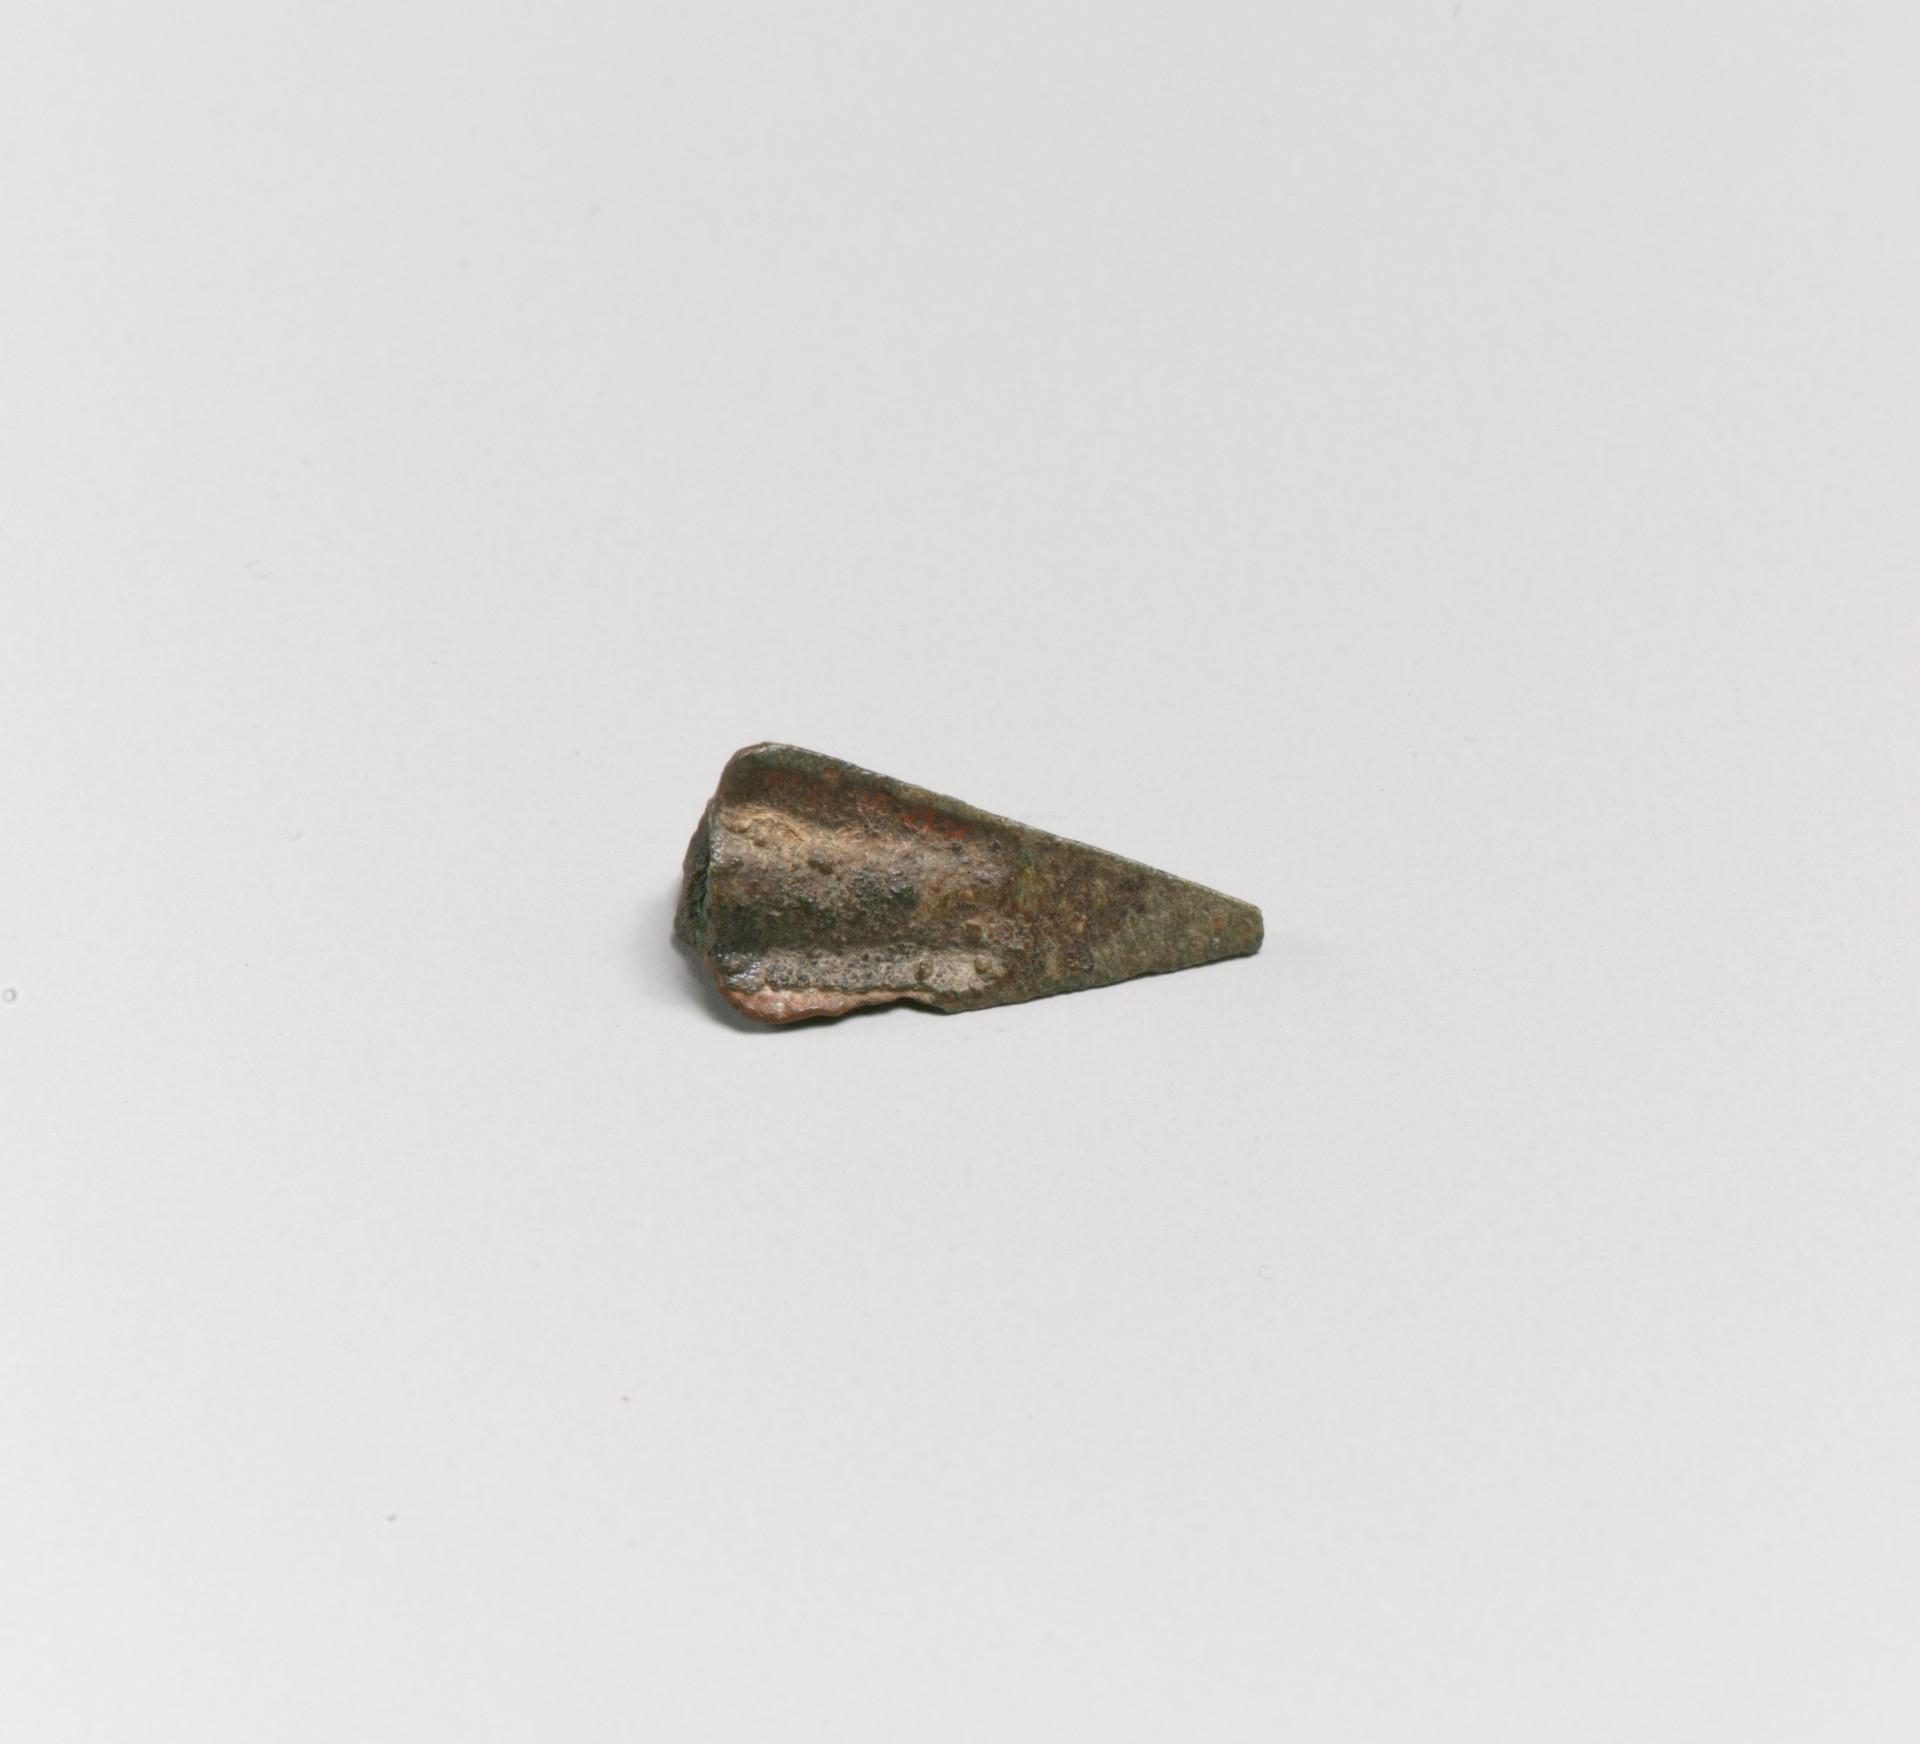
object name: arrowhead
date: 7000 BCE-330 CE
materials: bronze